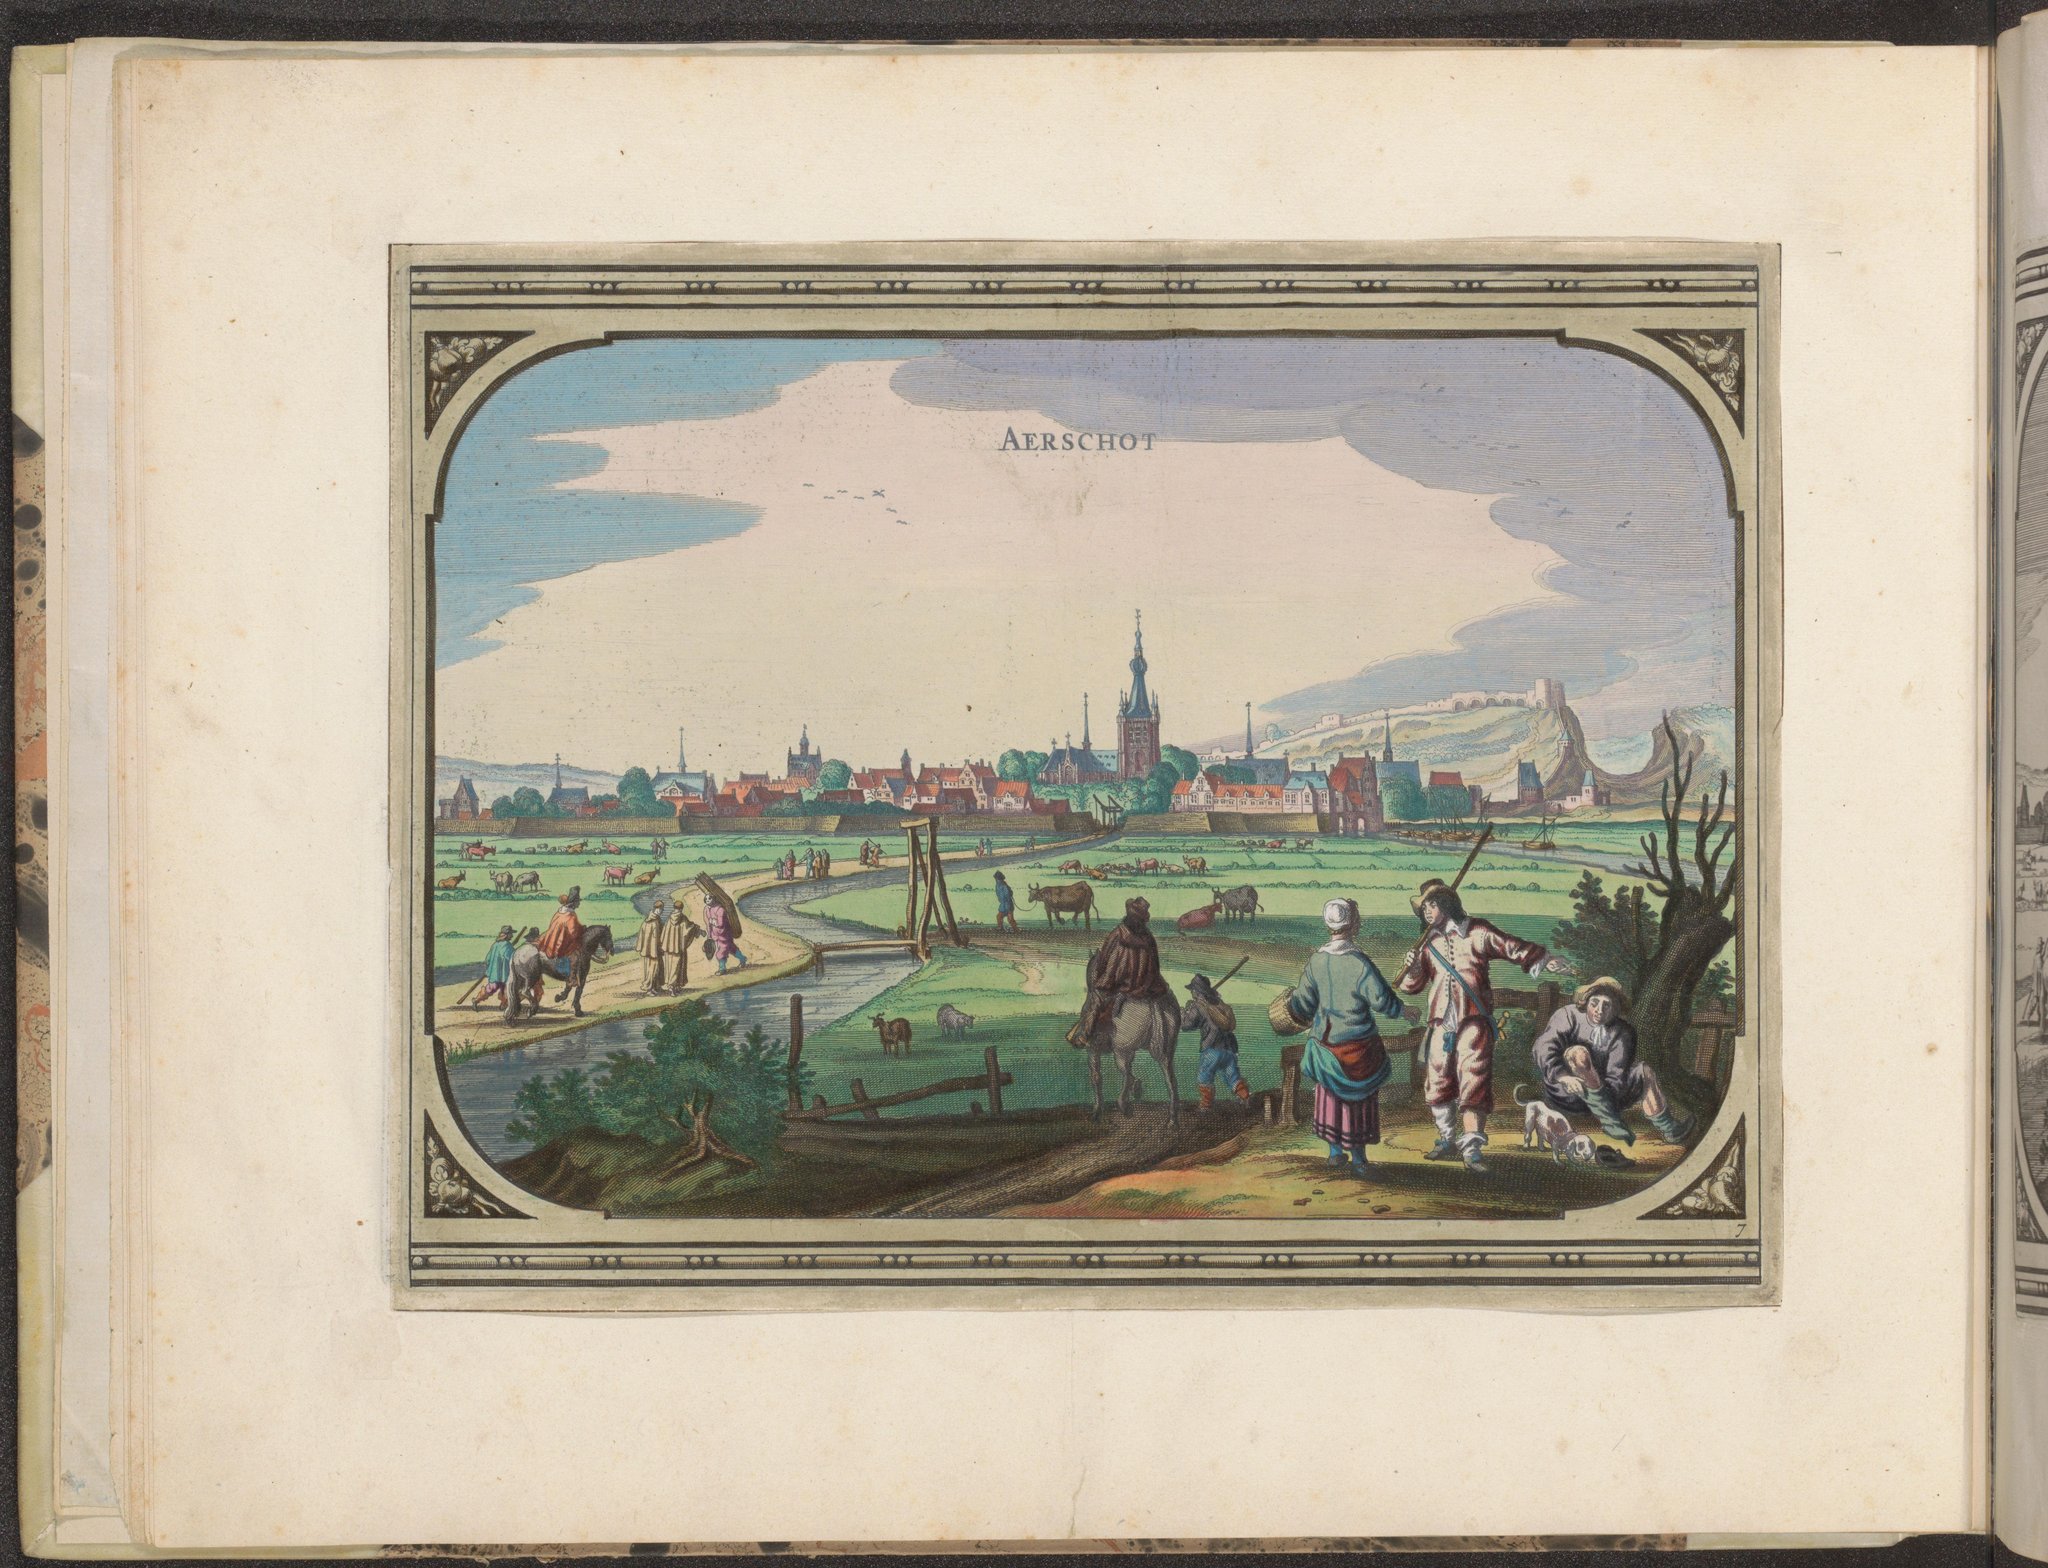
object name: album leaf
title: Theatrum praecipuarum urbium ducatus Brabantiae necnon comitatuum Flandriae et Zelandiae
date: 1657-1667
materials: paper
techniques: etching, hand coloring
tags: animal traction, animal-drawn vehicle (carriage etc.), city-view, and landscape with man-made constructions, pedlar, 'en route', traveller under way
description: Gezicht op de stad Tienen. Op de voorgrond zitten drie jongens bij een hek. Verderop kijkt een meisje naar de hond die blaft naar eenwegrijdende huifkar. Rechts loopt een marskramer. De prent maakt deel uit van een album.